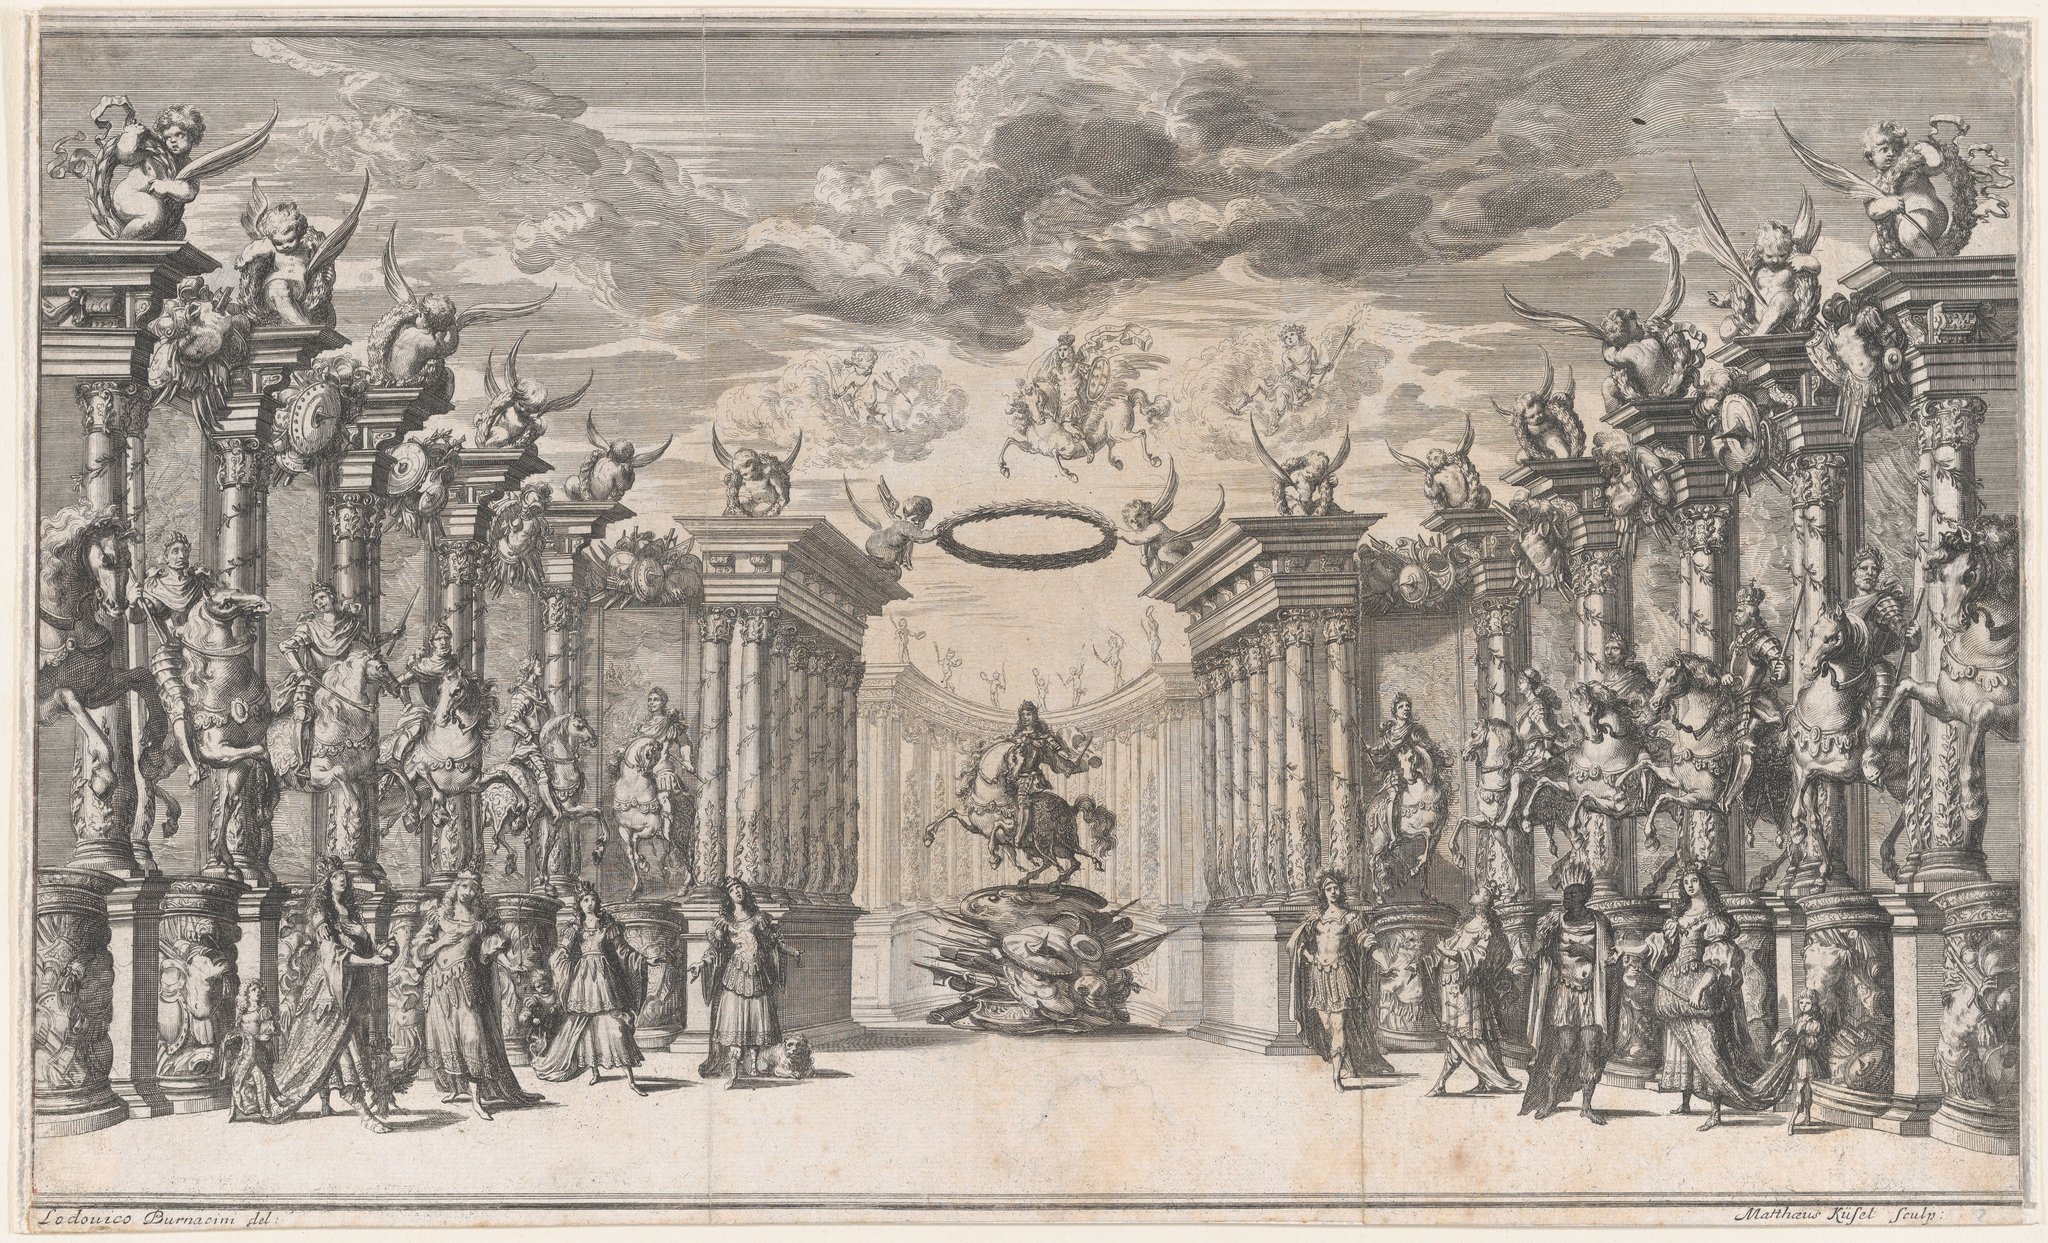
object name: print, fete, ornament architecture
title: The Triumph of Austria; Leopold I at center, mounted on a reared horse, atop a military trophy; surrounded by equestrian portraits of the Holy Roman Emperors; set design from 'Il Pomo D'Oro'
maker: mathäus küsel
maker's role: artist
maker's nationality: german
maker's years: 1621-1682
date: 1668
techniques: etching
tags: men,women,cupid,horses